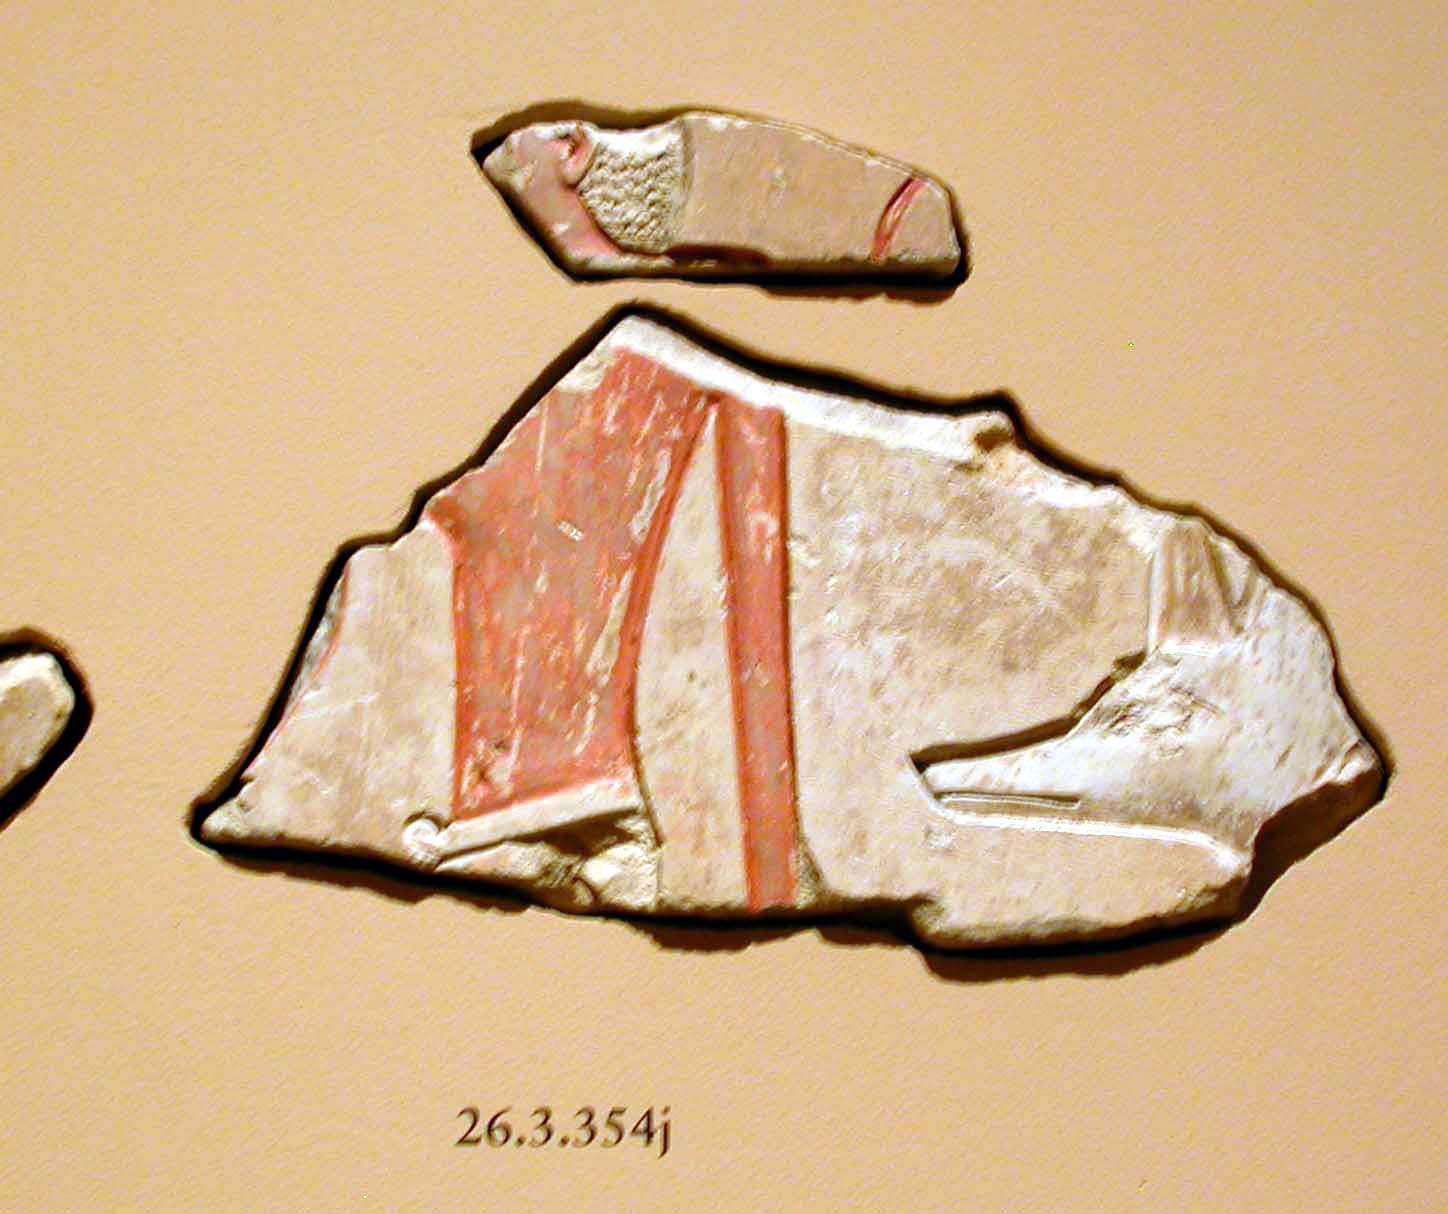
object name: relief, tomb of khety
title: Relief, tomb of Khety: man with dog - see 26.3.354-3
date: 2051-2000 BCE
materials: limestone, paint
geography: egypt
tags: dogs